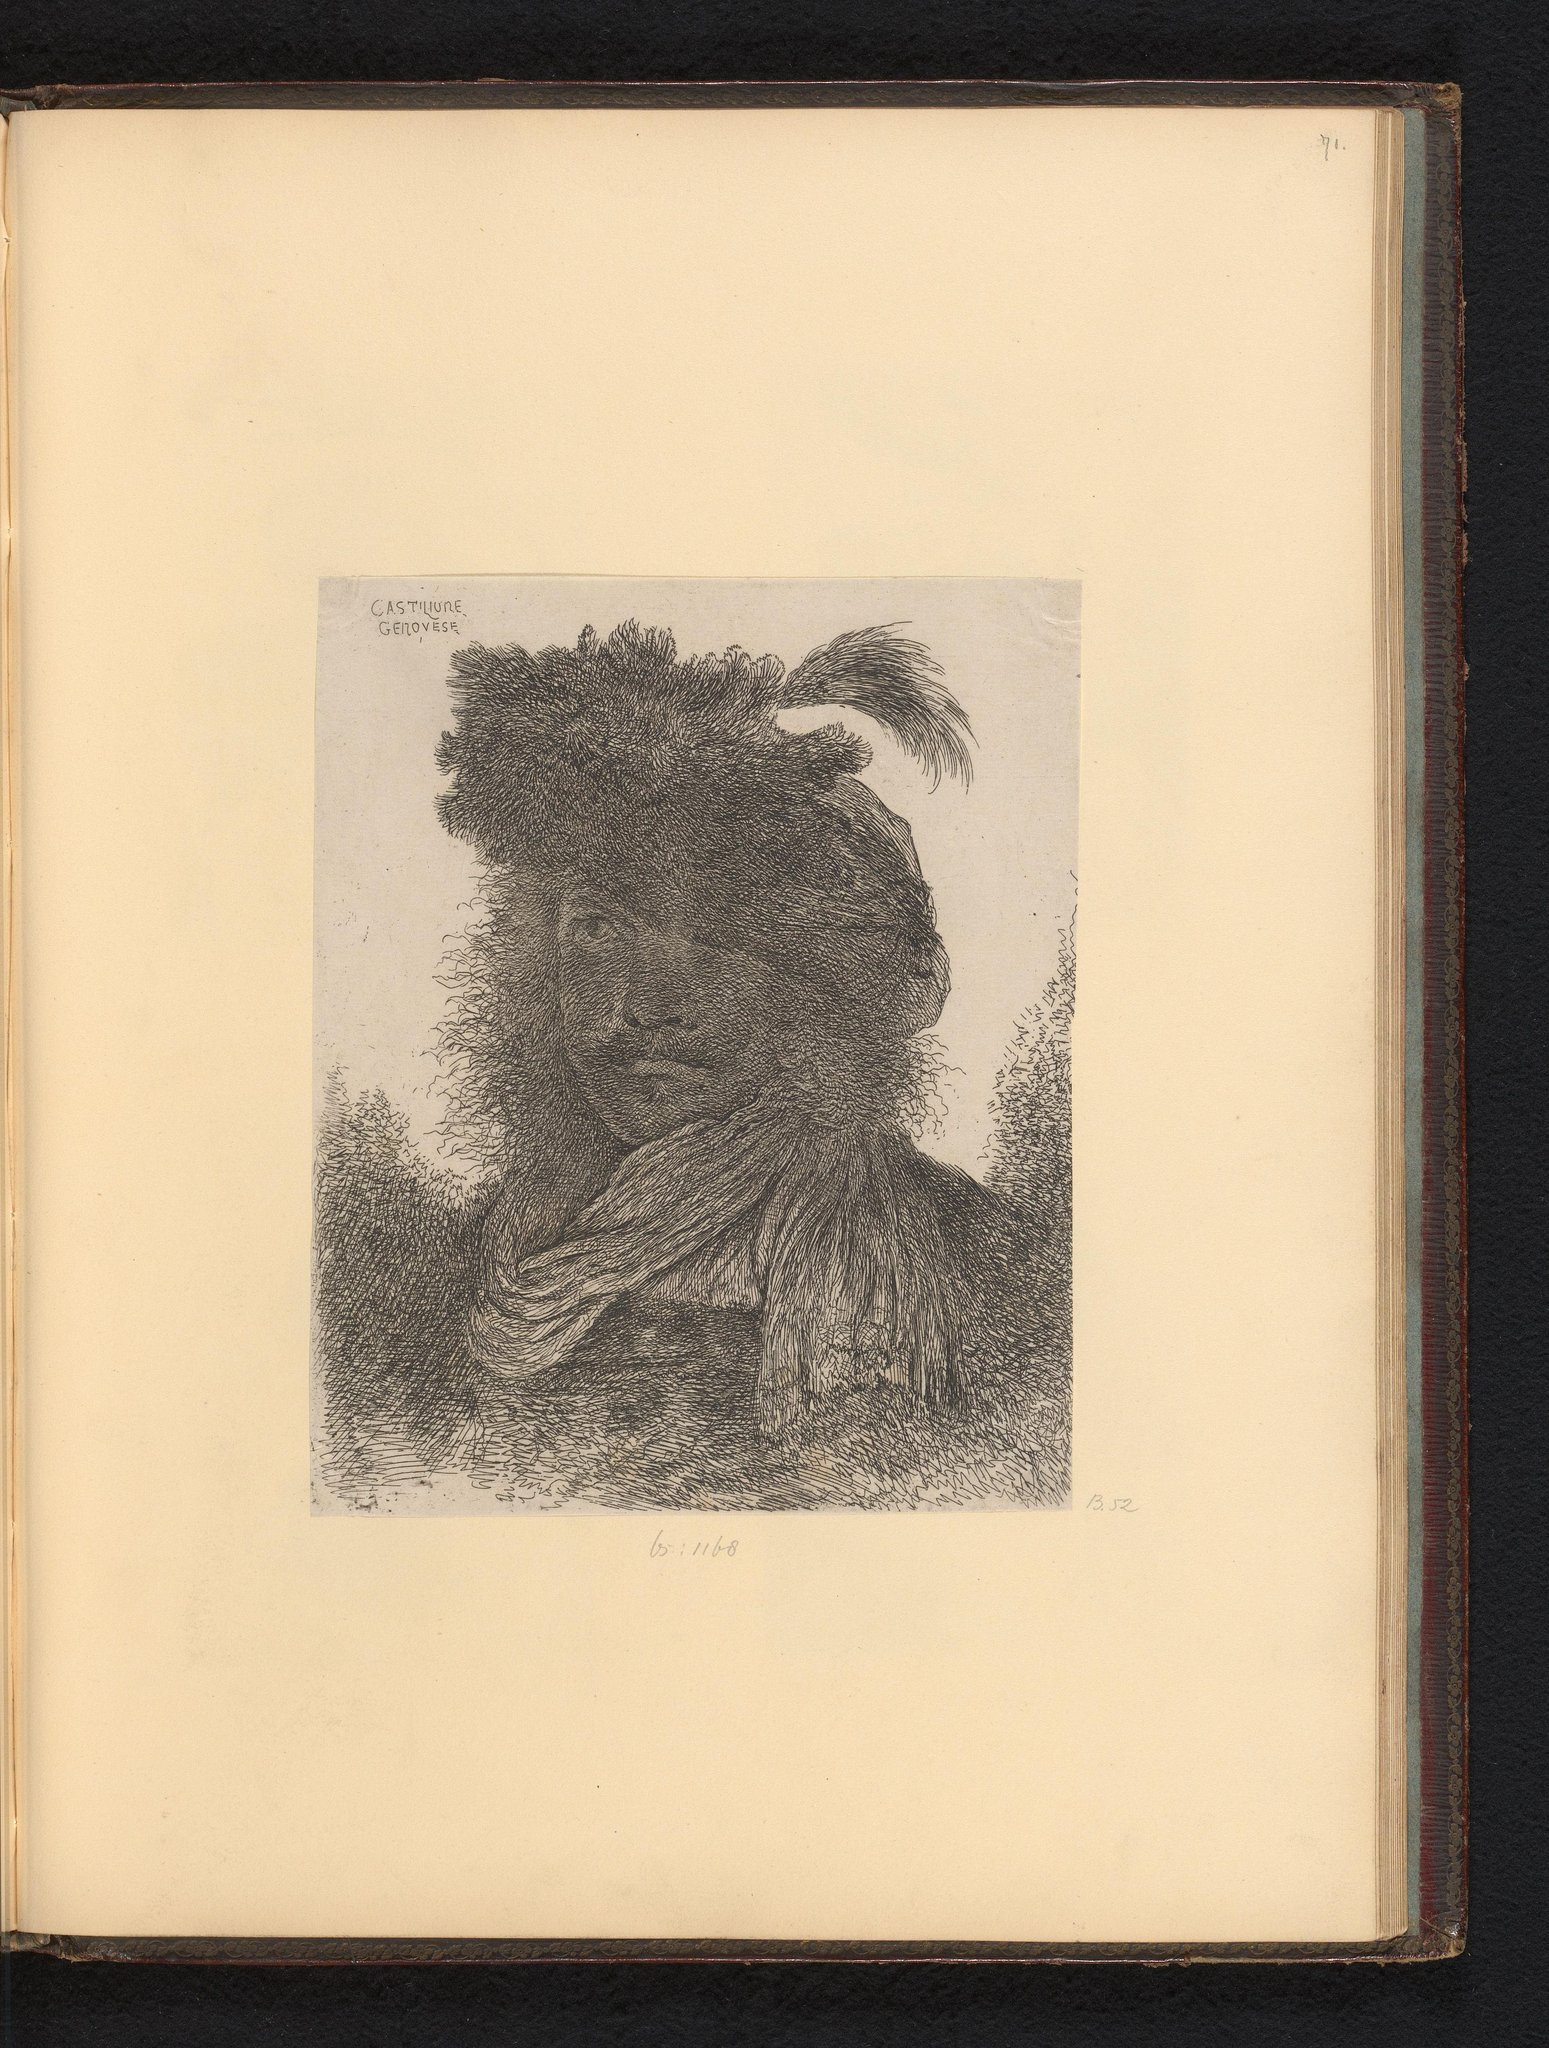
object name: print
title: Hoofd van man in de schaduw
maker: giovanni benedetto castiglione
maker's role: draughtsman, print maker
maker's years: 1610-1665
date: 1645-1650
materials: paper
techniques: etching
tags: head (human), head-gear: cap (+ men's clothes), shadow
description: Prent uit een serie van zes prenten door Castiglione. Prent maakt mogelijk deel uit van een serie van 200 prenten. Deze serie is onder de titel 'A Collection of two hundred original etchings' voor het eerst uitgegeven door J.M. Greery in 1816.